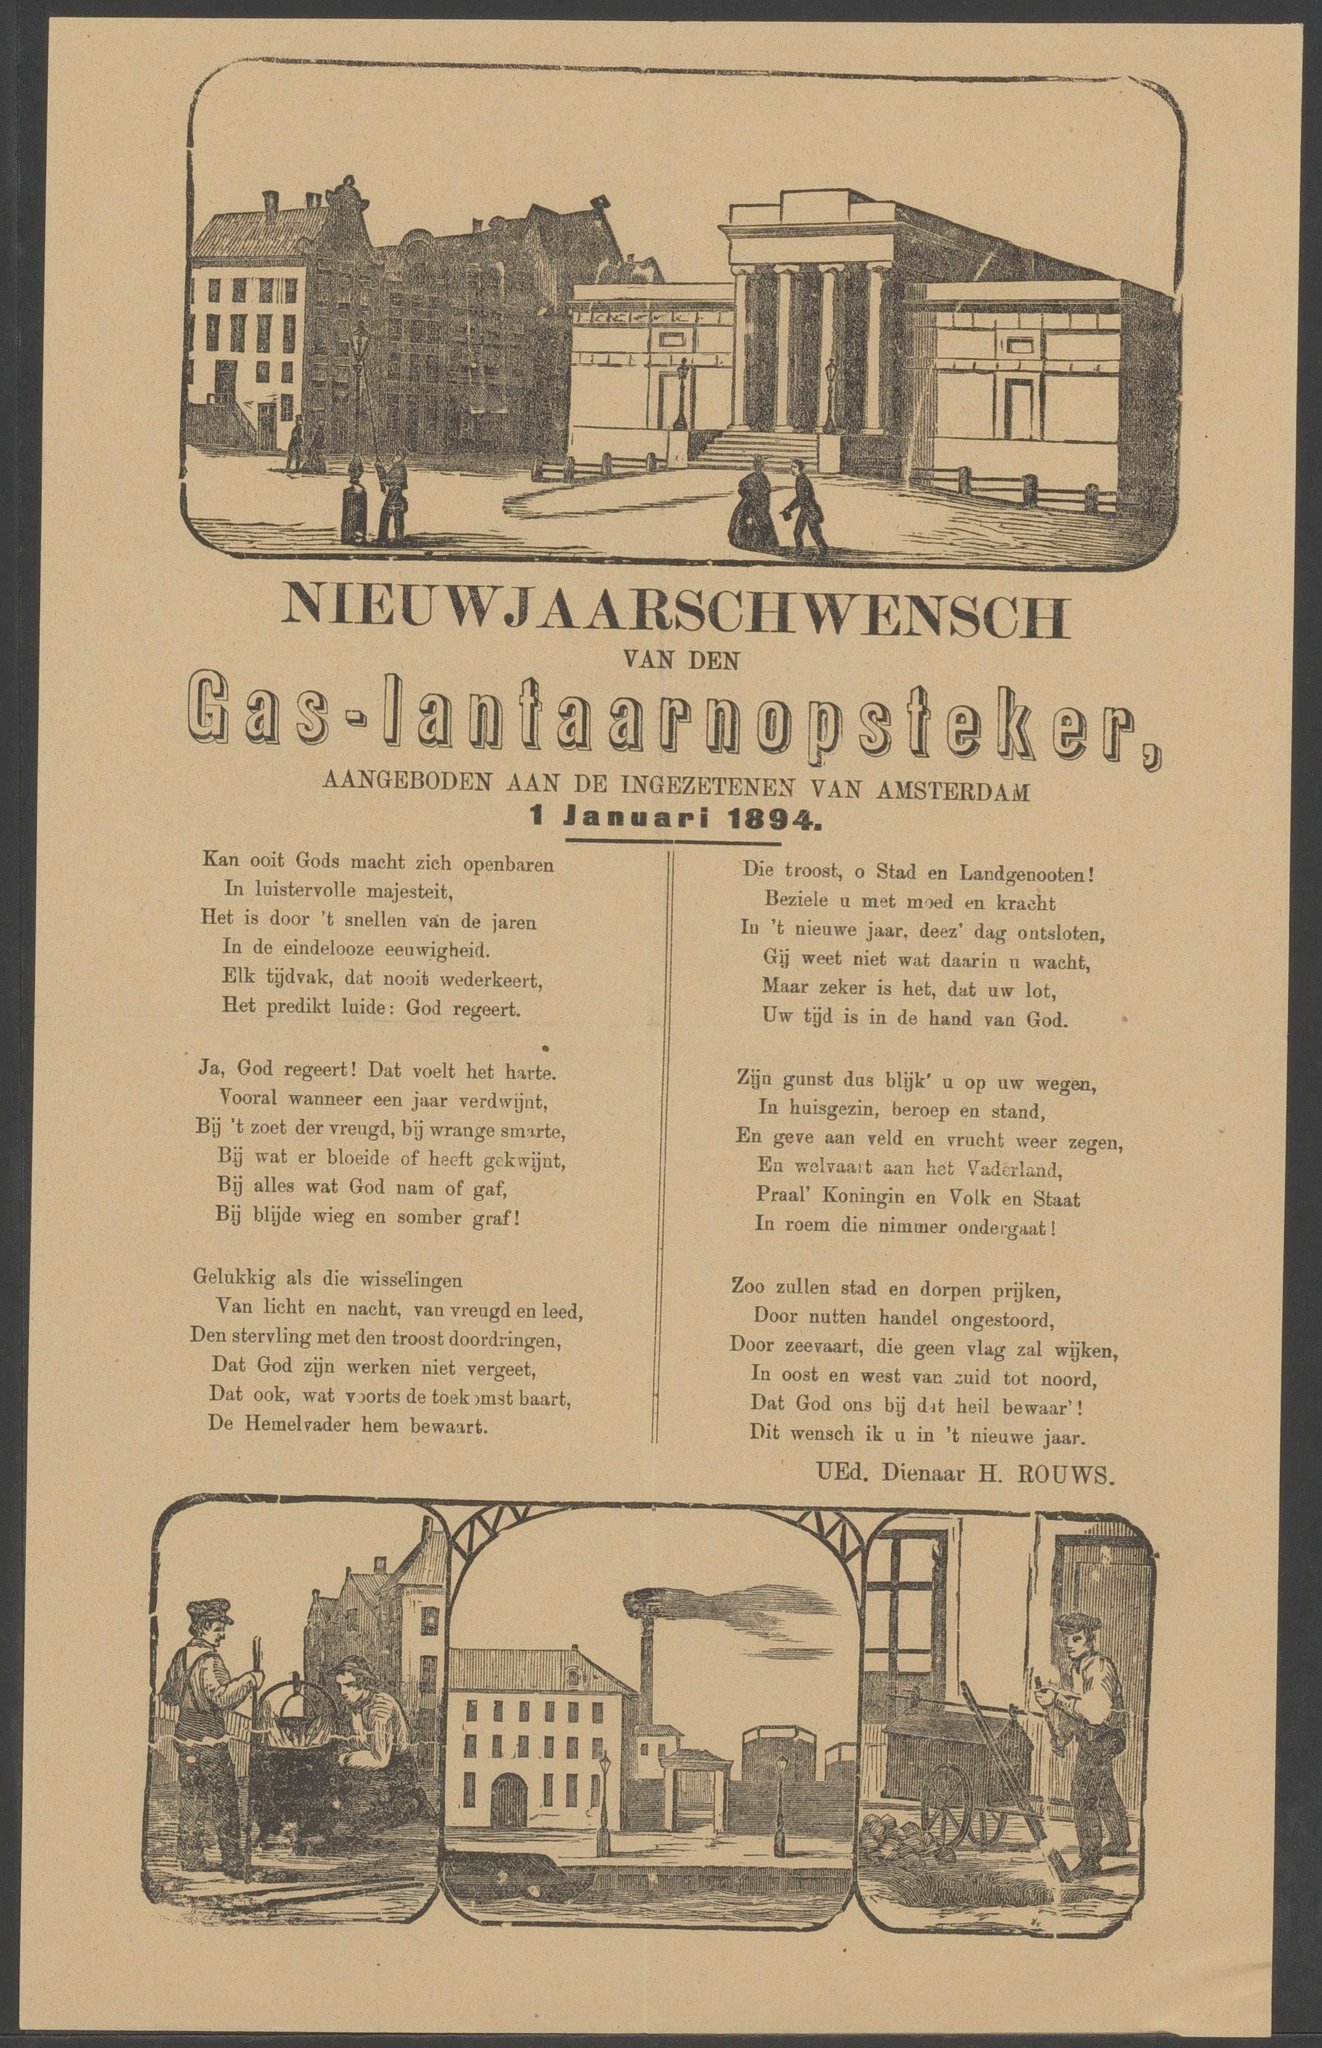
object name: print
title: Nieuwjaarschwensch van den Gas-lantaarnopsteker, aangeboden aan de ingezetenen van Amsterdam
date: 1884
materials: paper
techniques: letterpress printing, engraving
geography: amsterdam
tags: gas-lamp, gas supply, digging (industrial process), street lighting, amsterdam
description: Nieuwjaarswens van de Amsterdamse gaslantaarnopstekers voor het jaar 1884. Centraal een vers in twee kolommen. Bovenaan de Dam met de beurs van Zocher te Amsterdam. Onderaan de Hollandsche Gasfabriek en twee gasfitters aan het werk. Van de gaslantaarnopsteker: H. Rouws. Onderwerpsrubrieken binnen de Atlas Zeden en Gewoonten: Zeden en gewoonten in engeren zin, Volksleven, Volksbladen, Nieuwjaars- en Kerstwenschen, Amsterdam.